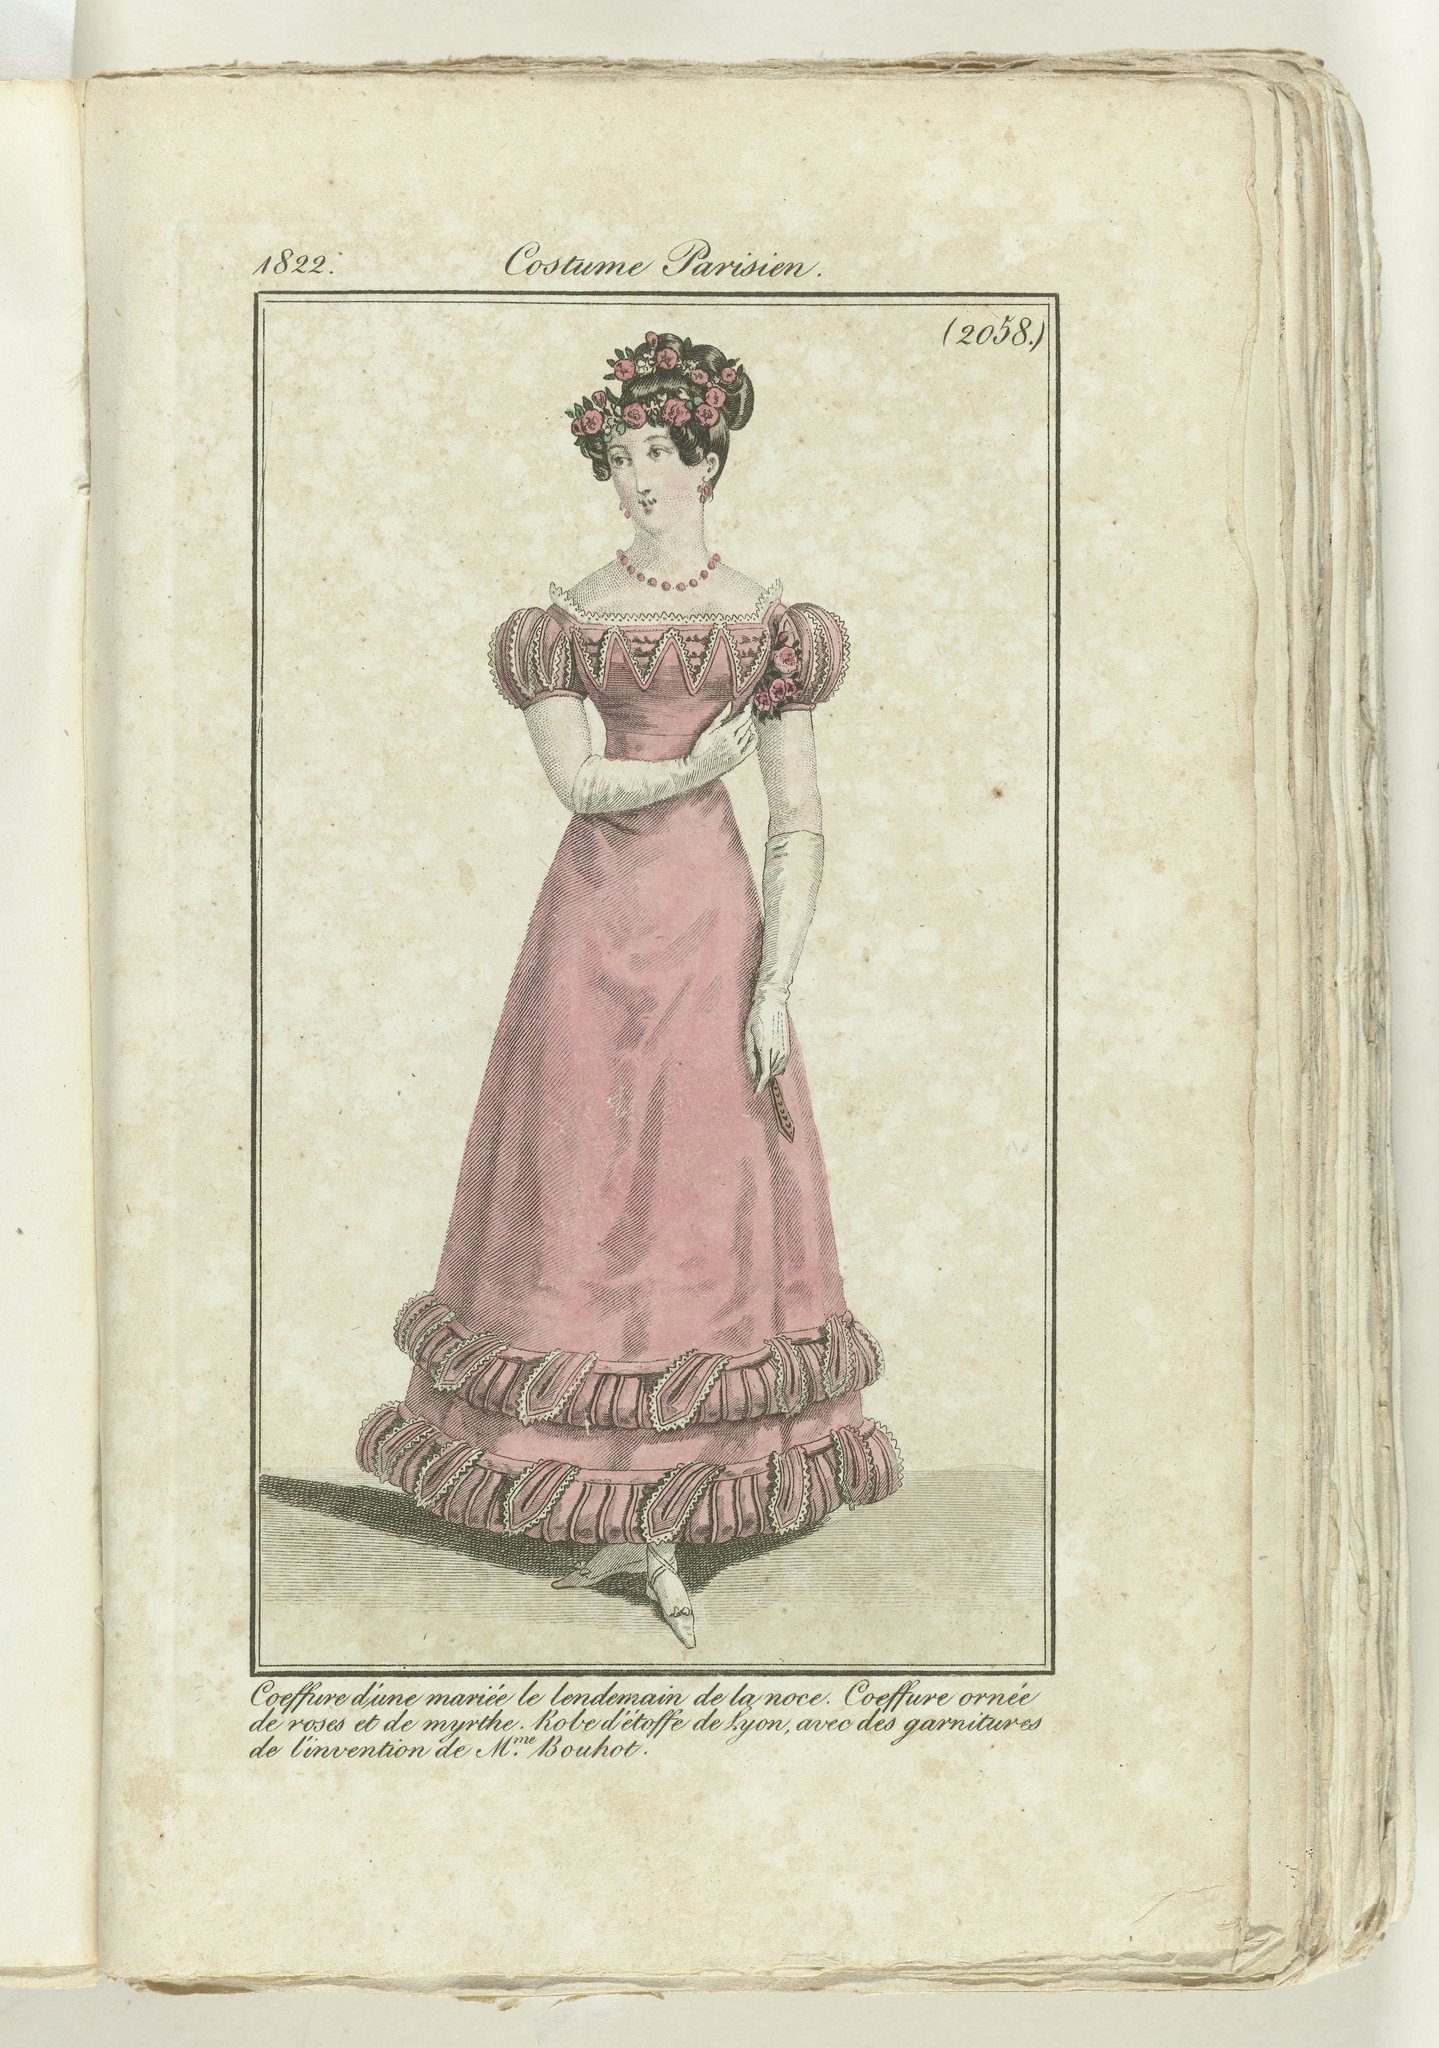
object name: fashion print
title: Journal des Dames et des Modes 1822, Costume Parisien (2058)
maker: Anonymous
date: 1822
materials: paper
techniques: etching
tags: fashion plates, clothes, costume (+ women's clothes)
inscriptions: date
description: Prent uit het tijdschrift Journal des Dames et des Modes, 1822.